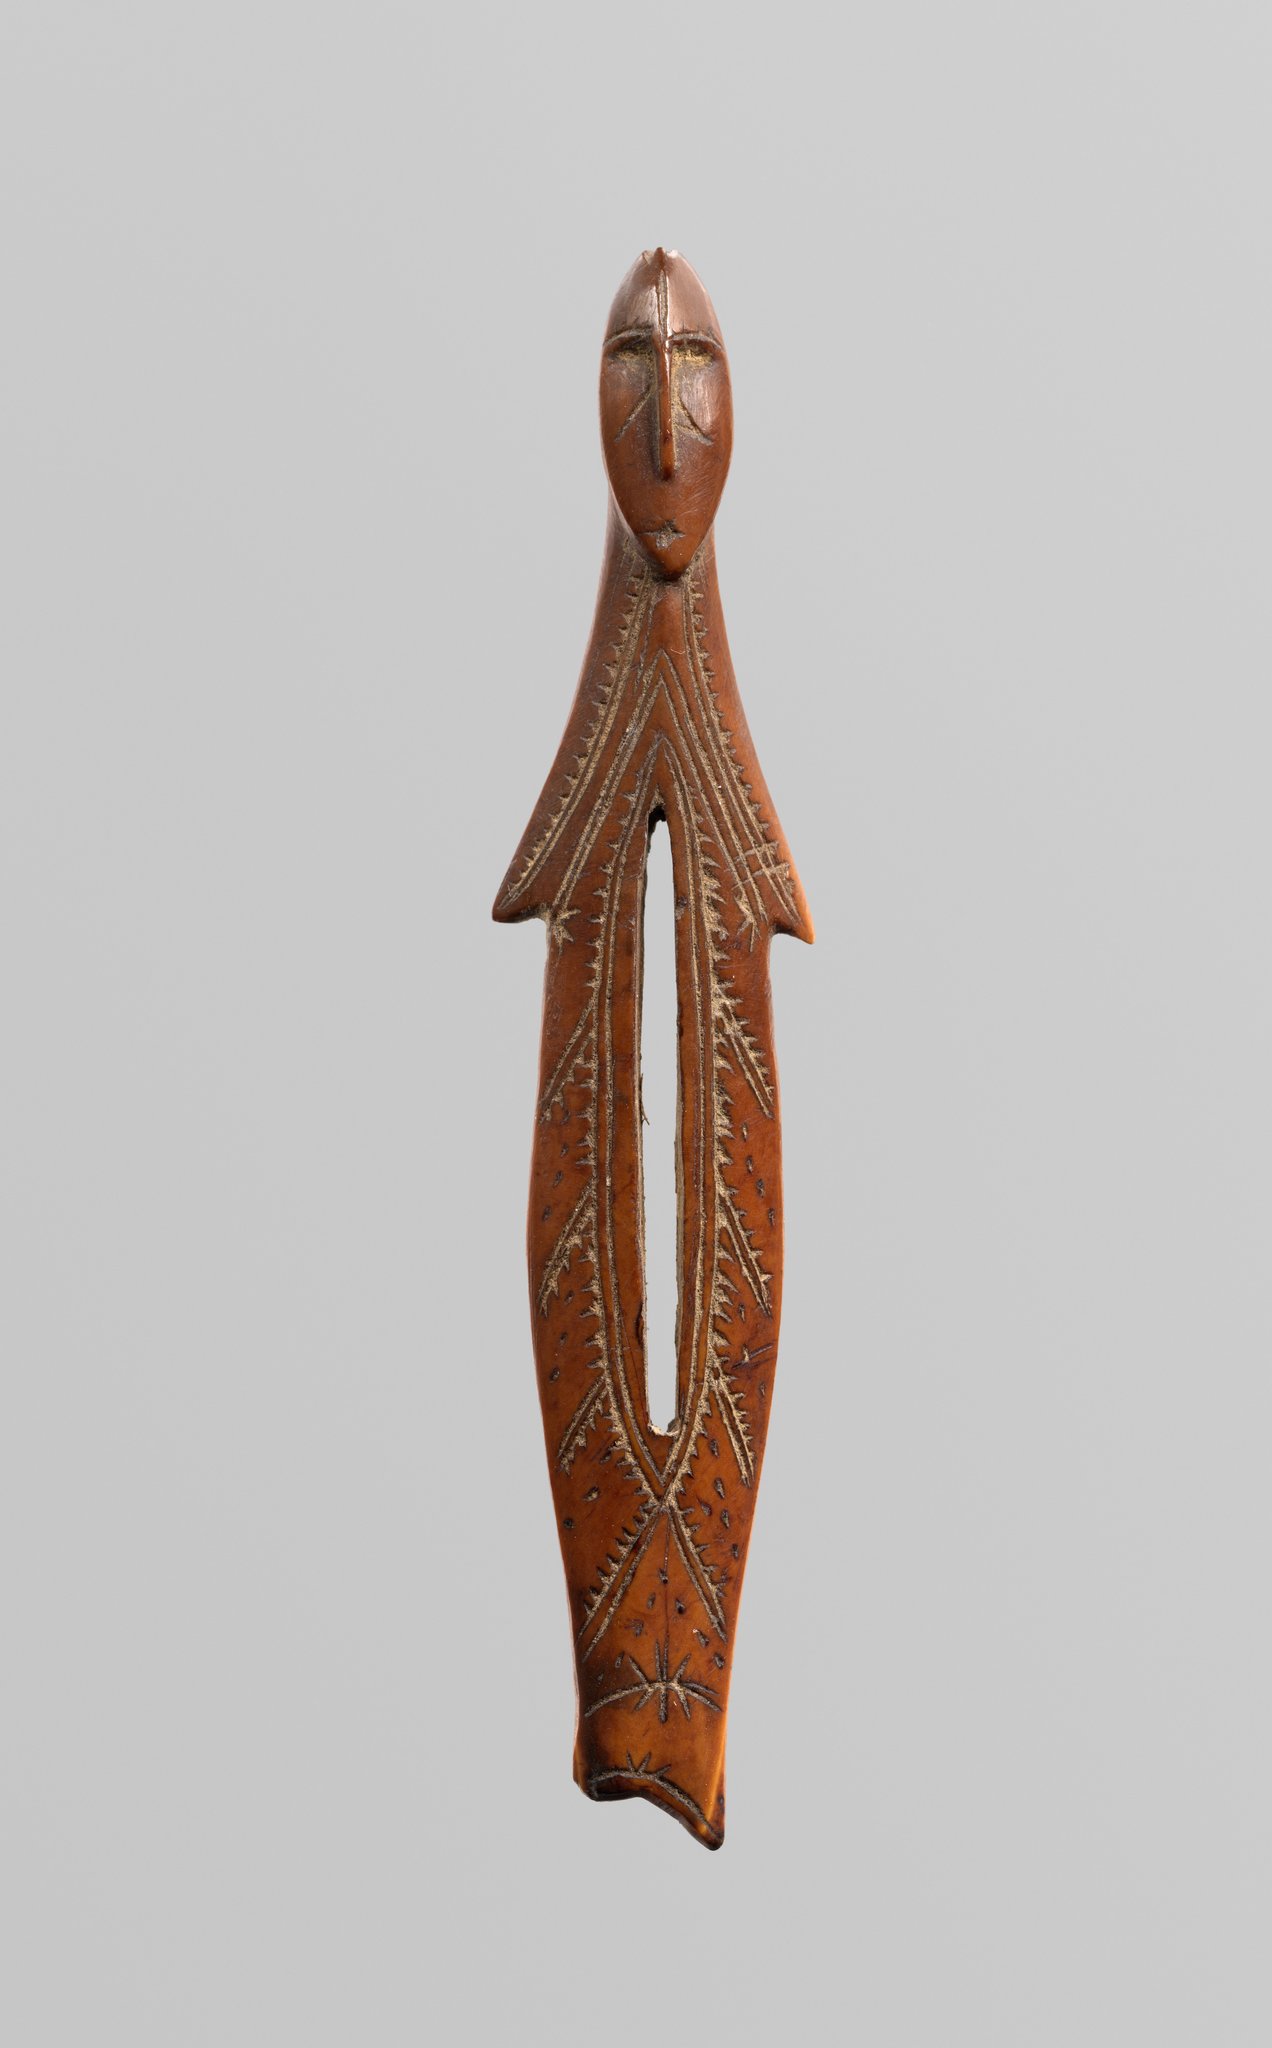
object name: transformational figure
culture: okvik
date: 200 BCE-100 CE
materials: ivory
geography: united states